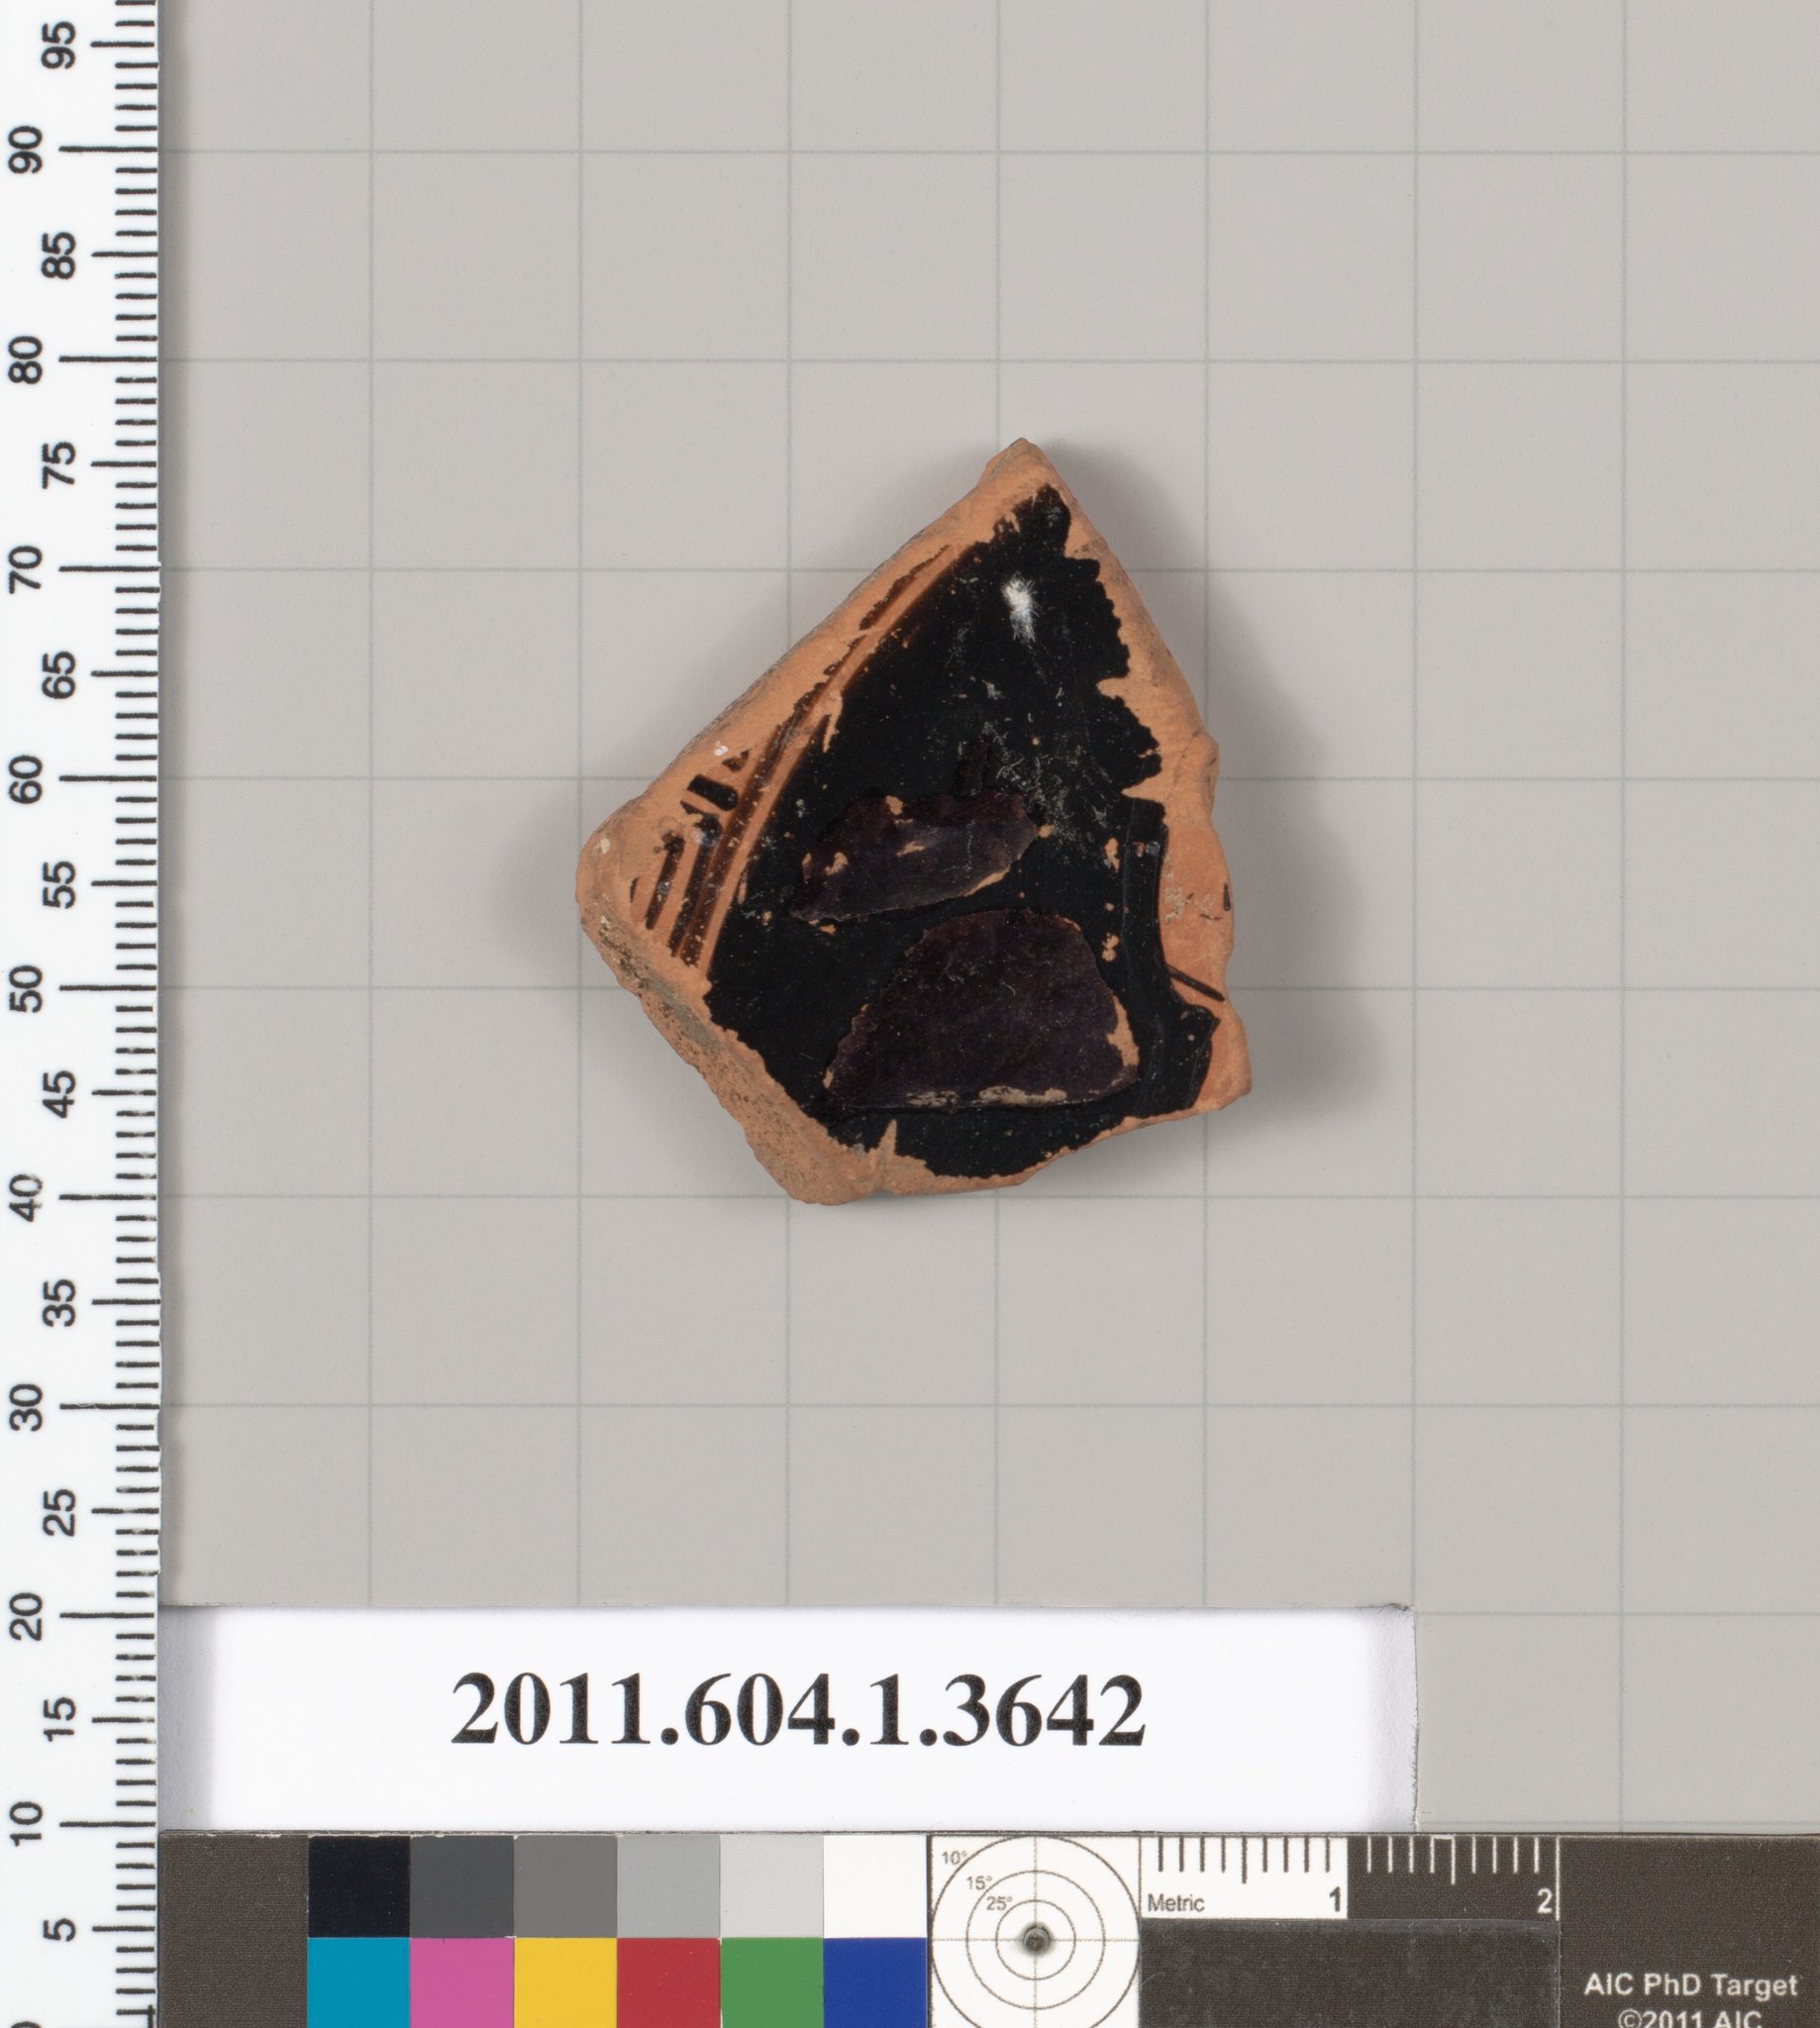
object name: kylix fragment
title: Terracotta fragment of a kylix (drinking cup)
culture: greek, attic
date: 475-451 BCE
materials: terracotta